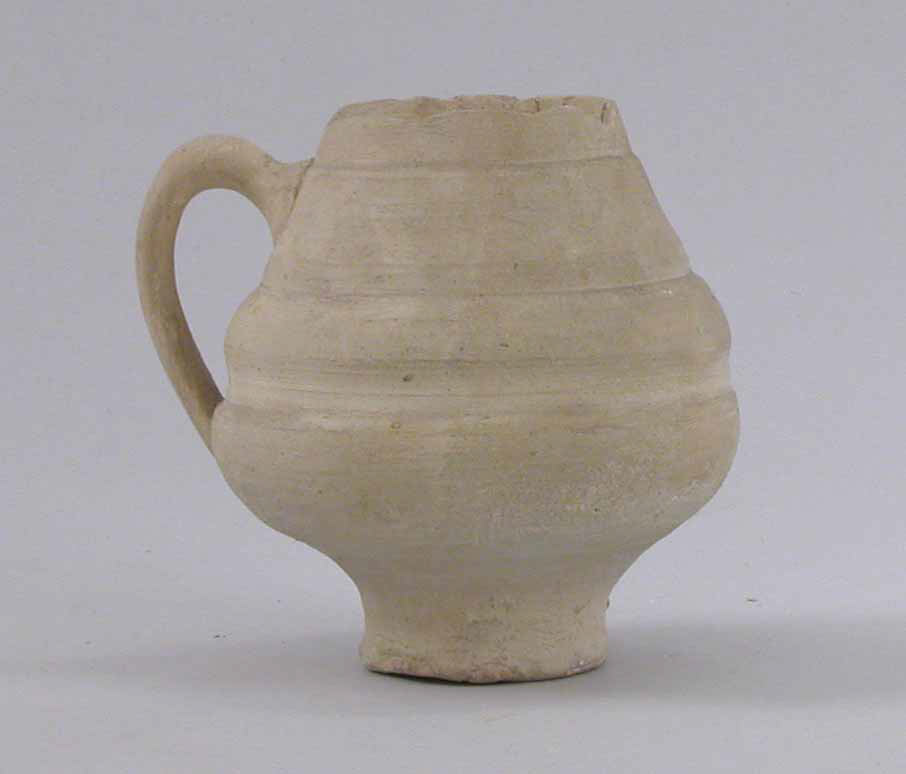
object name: cup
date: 801-1000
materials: earthenware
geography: iran